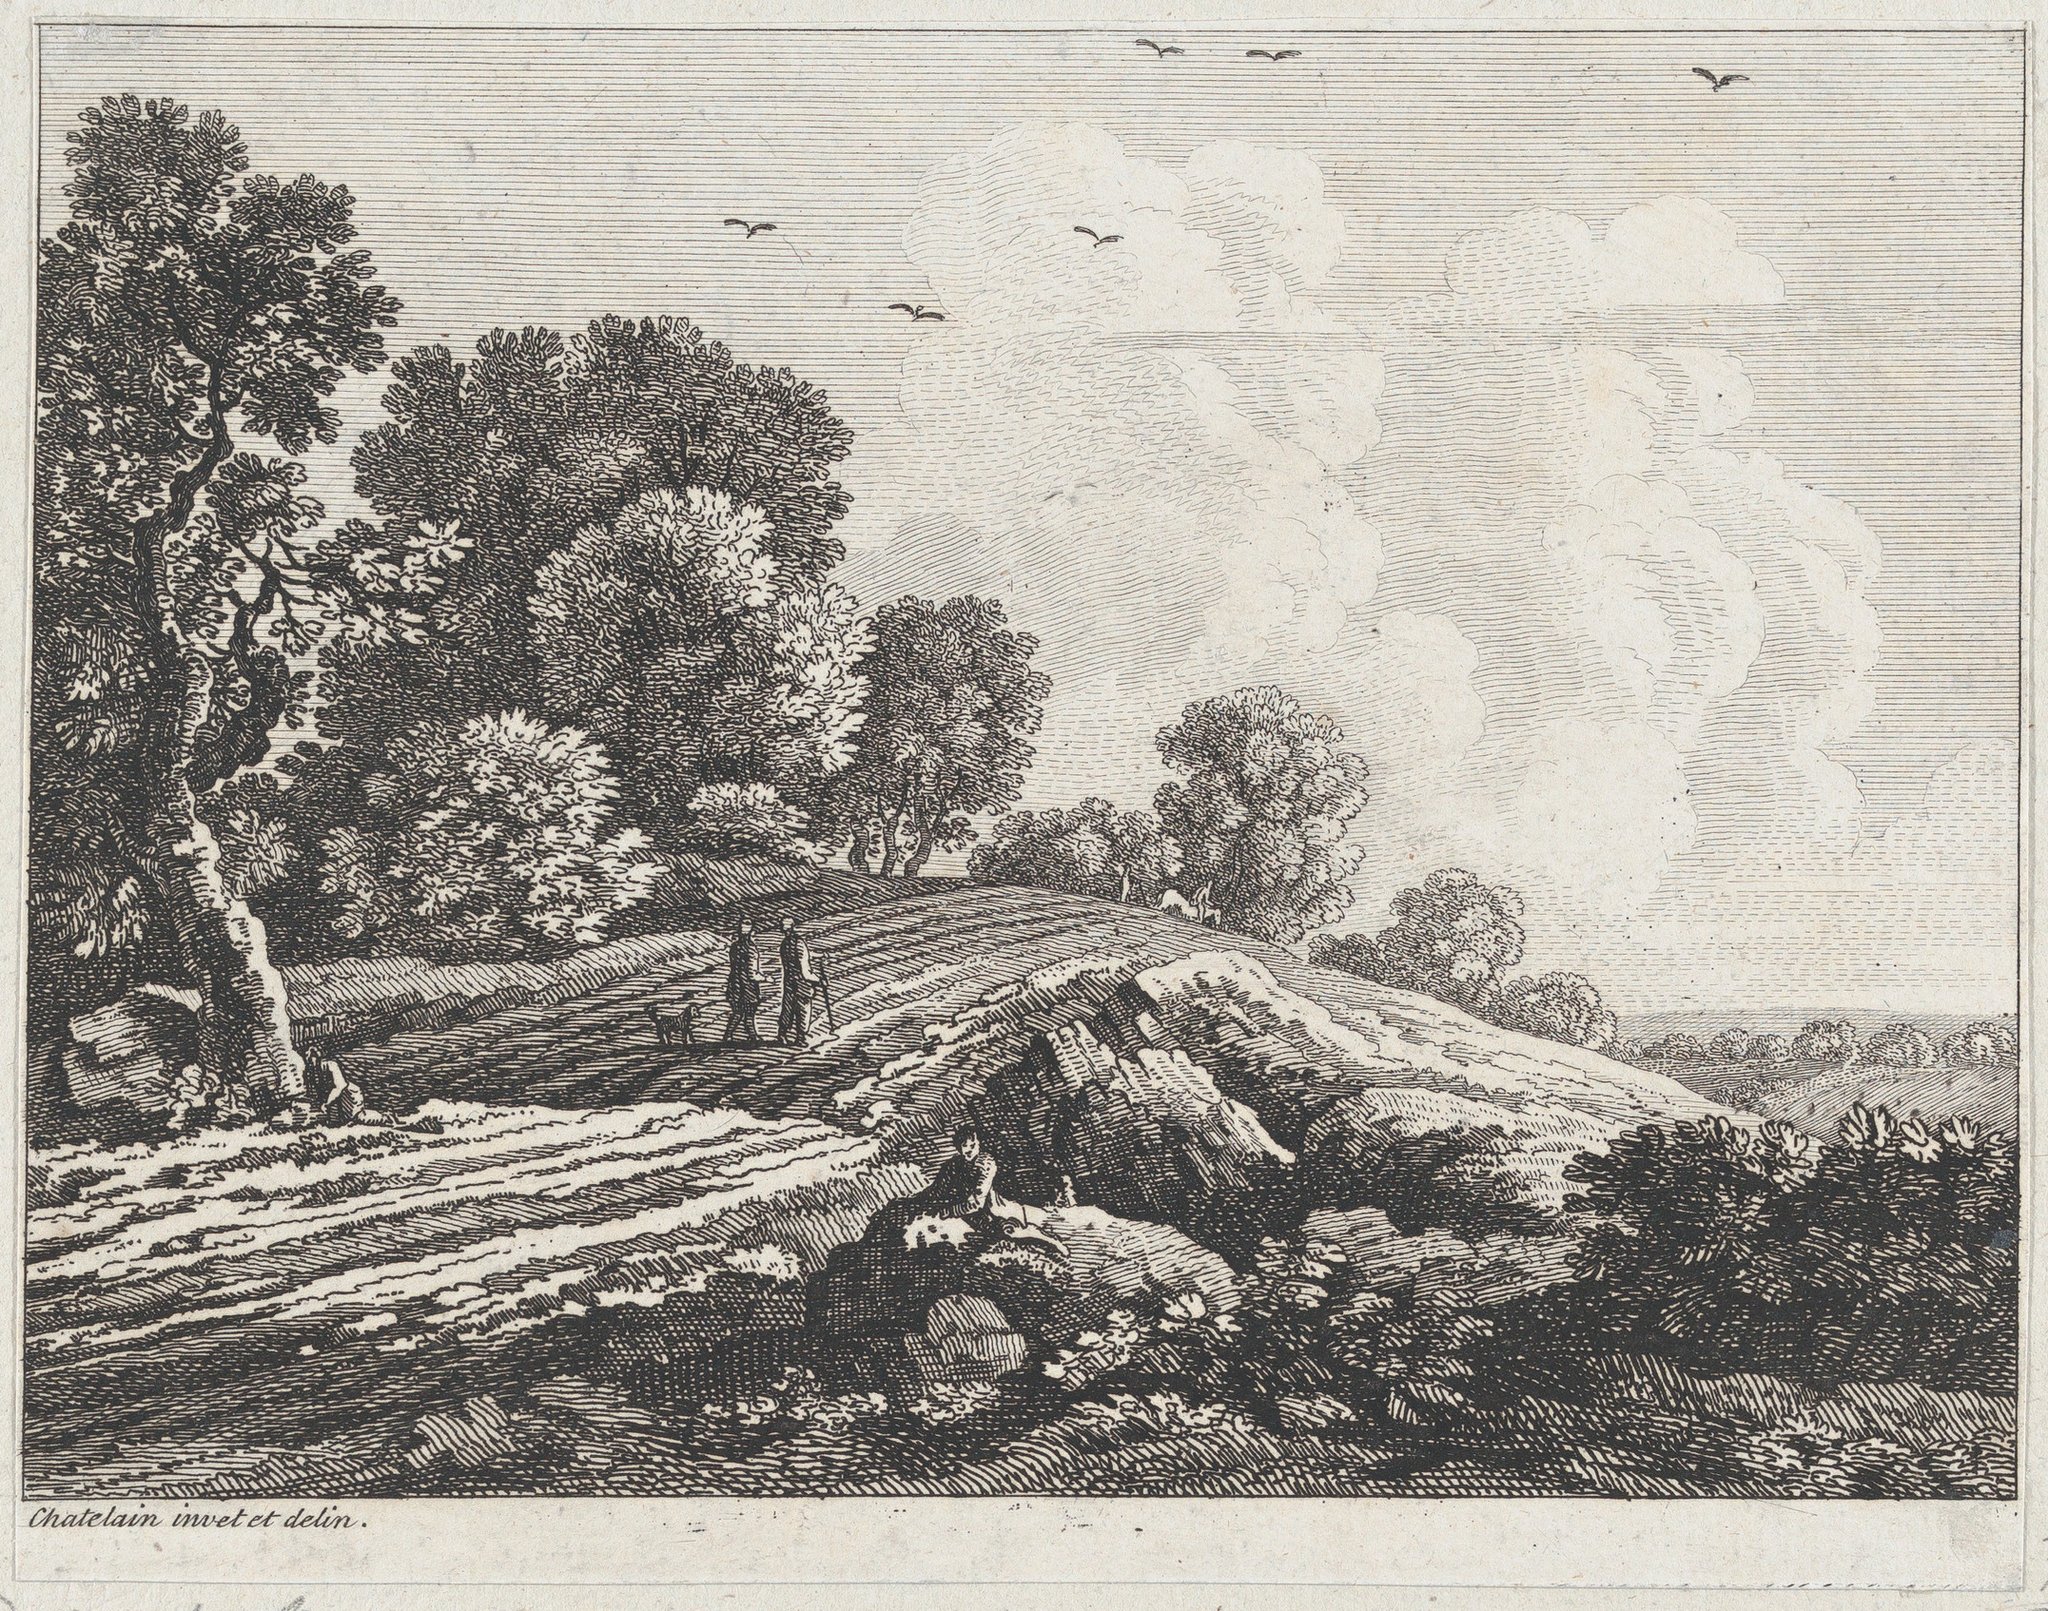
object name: print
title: Landscape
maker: jean-baptiste-claude chatelain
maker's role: artist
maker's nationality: british, french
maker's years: 1705-1758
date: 1730-1758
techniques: etching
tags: landscapes,trees